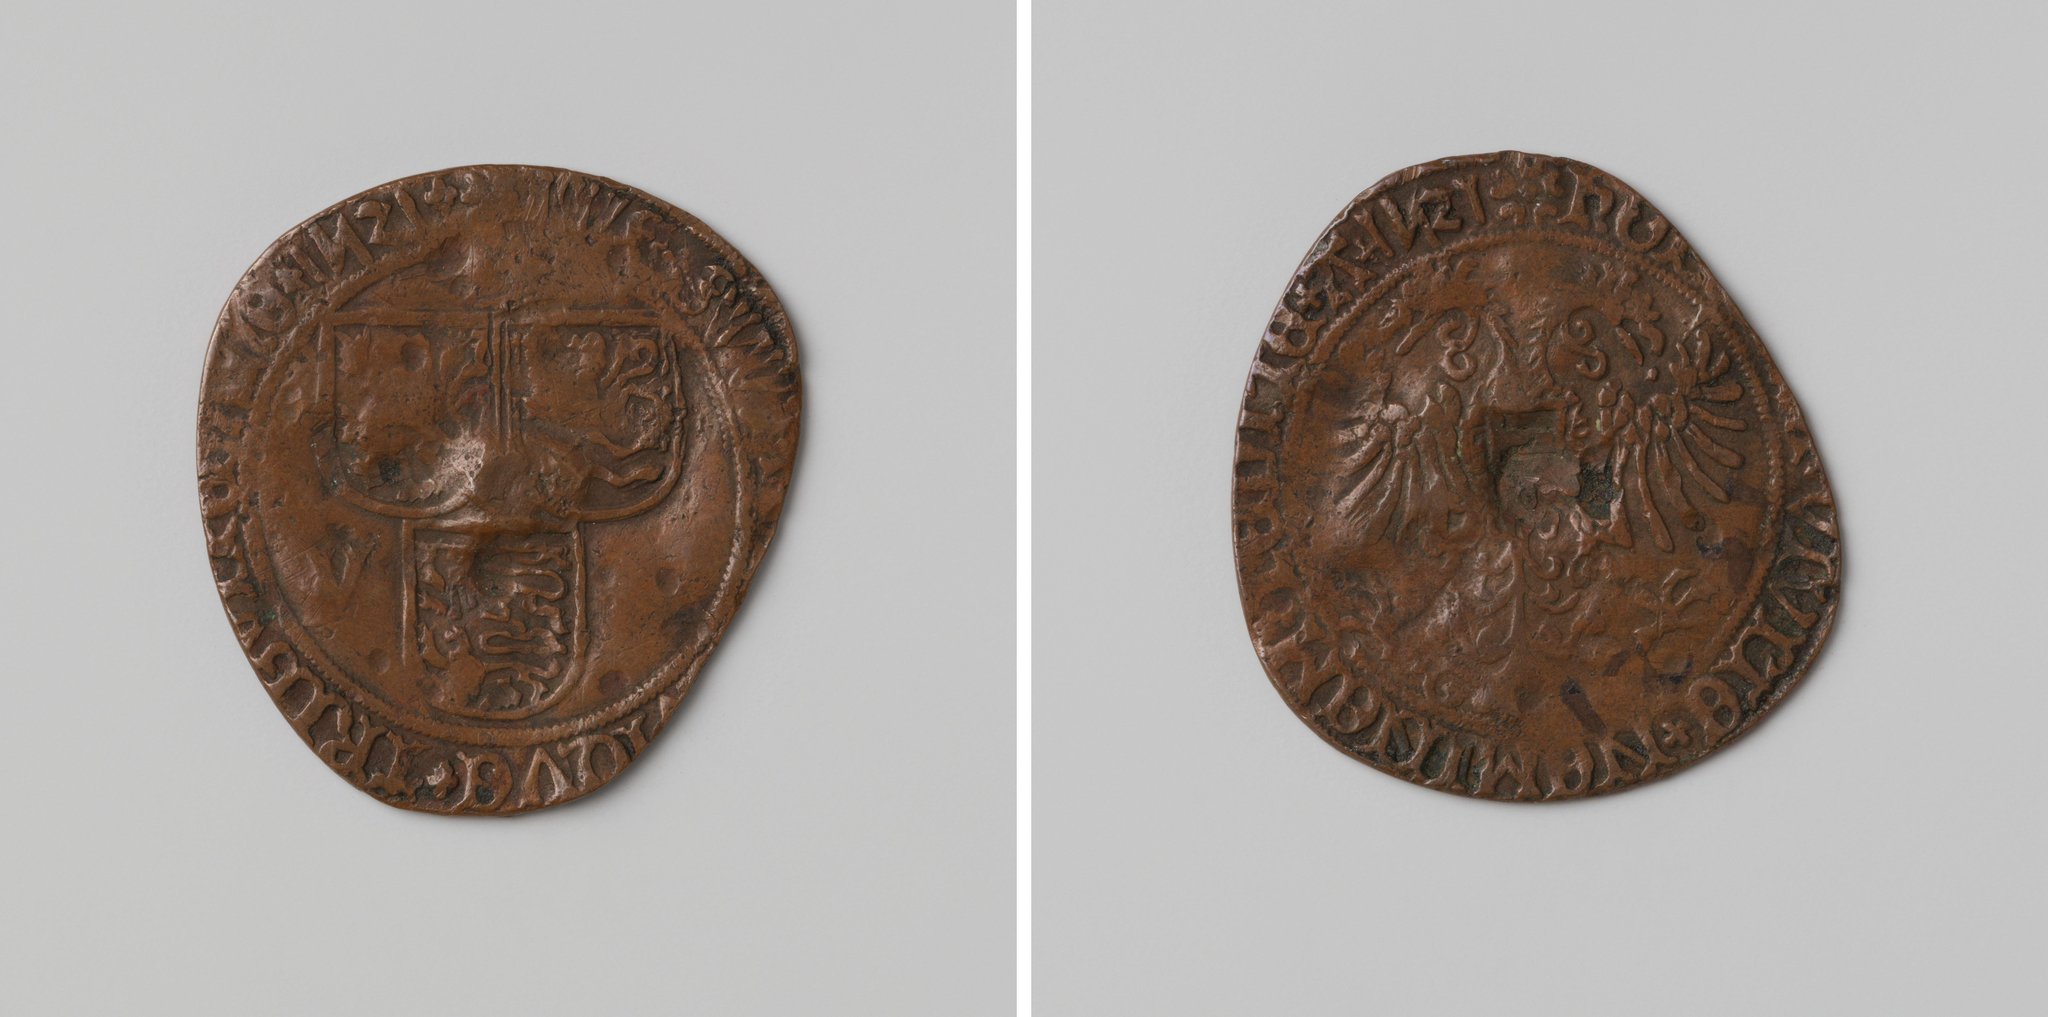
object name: jeton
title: Overwinningen van Karel V, Duits keizer, in de oorlog tegen Frankrijk, rekenpenning van Holland, Zeeland en Friesland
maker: Anonymous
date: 1515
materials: copper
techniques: striking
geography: netherlands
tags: ghent, charles v (holy roman emperor and king of spain), zeeland, holland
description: Koperen penning. Voorzijde: twee wapenschilden, geplaatst boven derde wapenschild binnen omschrift. Keerzijde: tweekoppige adelaar met later ingestempeld wapenschild op borst binnen omschrift